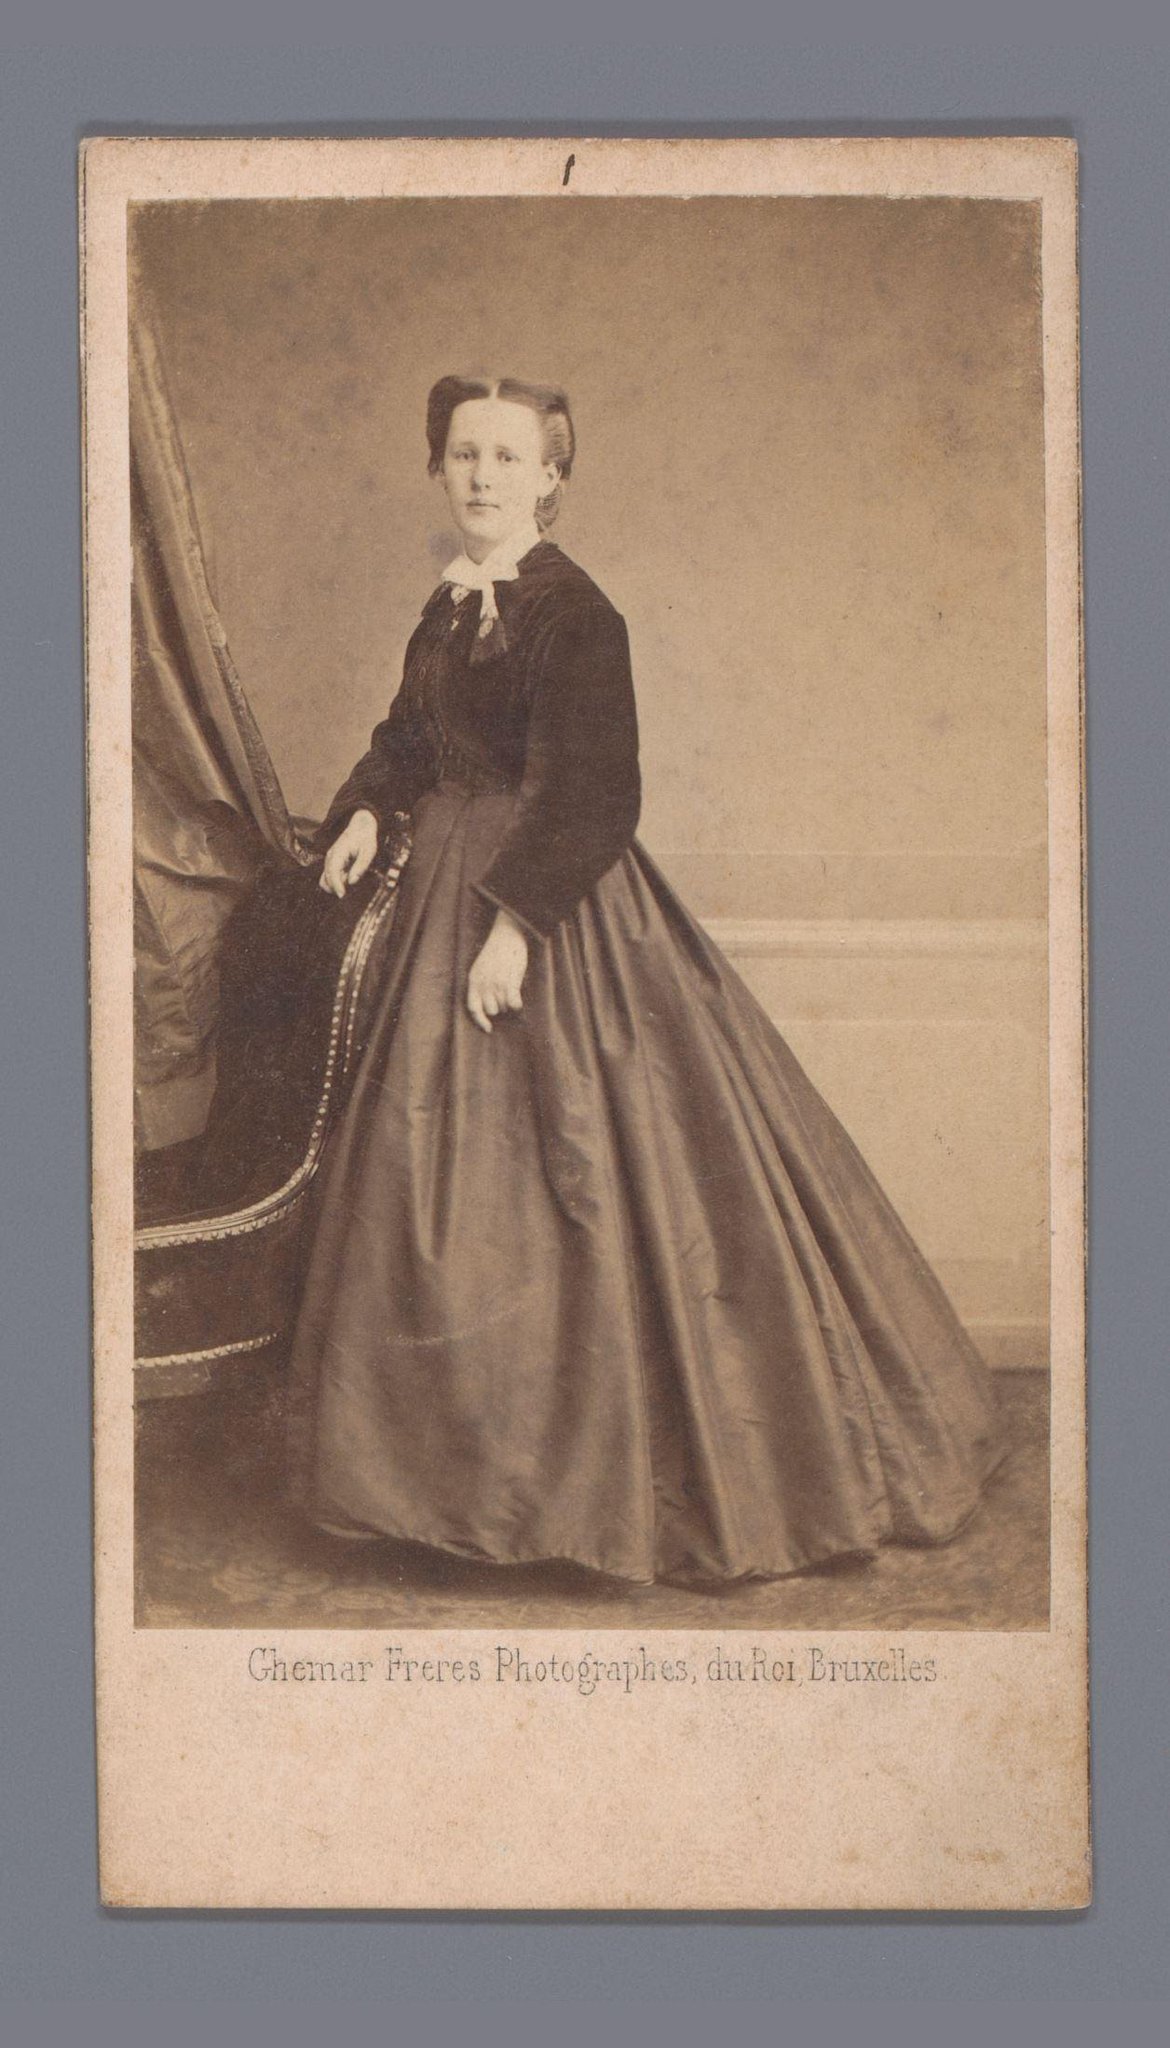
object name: photograph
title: Portret van een onbekende vrouw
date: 1859-1885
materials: cardboard, paper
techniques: albumen print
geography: brussels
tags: adult woman, anonymous historical person portrayed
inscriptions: address: ‘27, rue d l'Ecuyer,/ entrée par la porte cochère,/ BRUXELLES.’